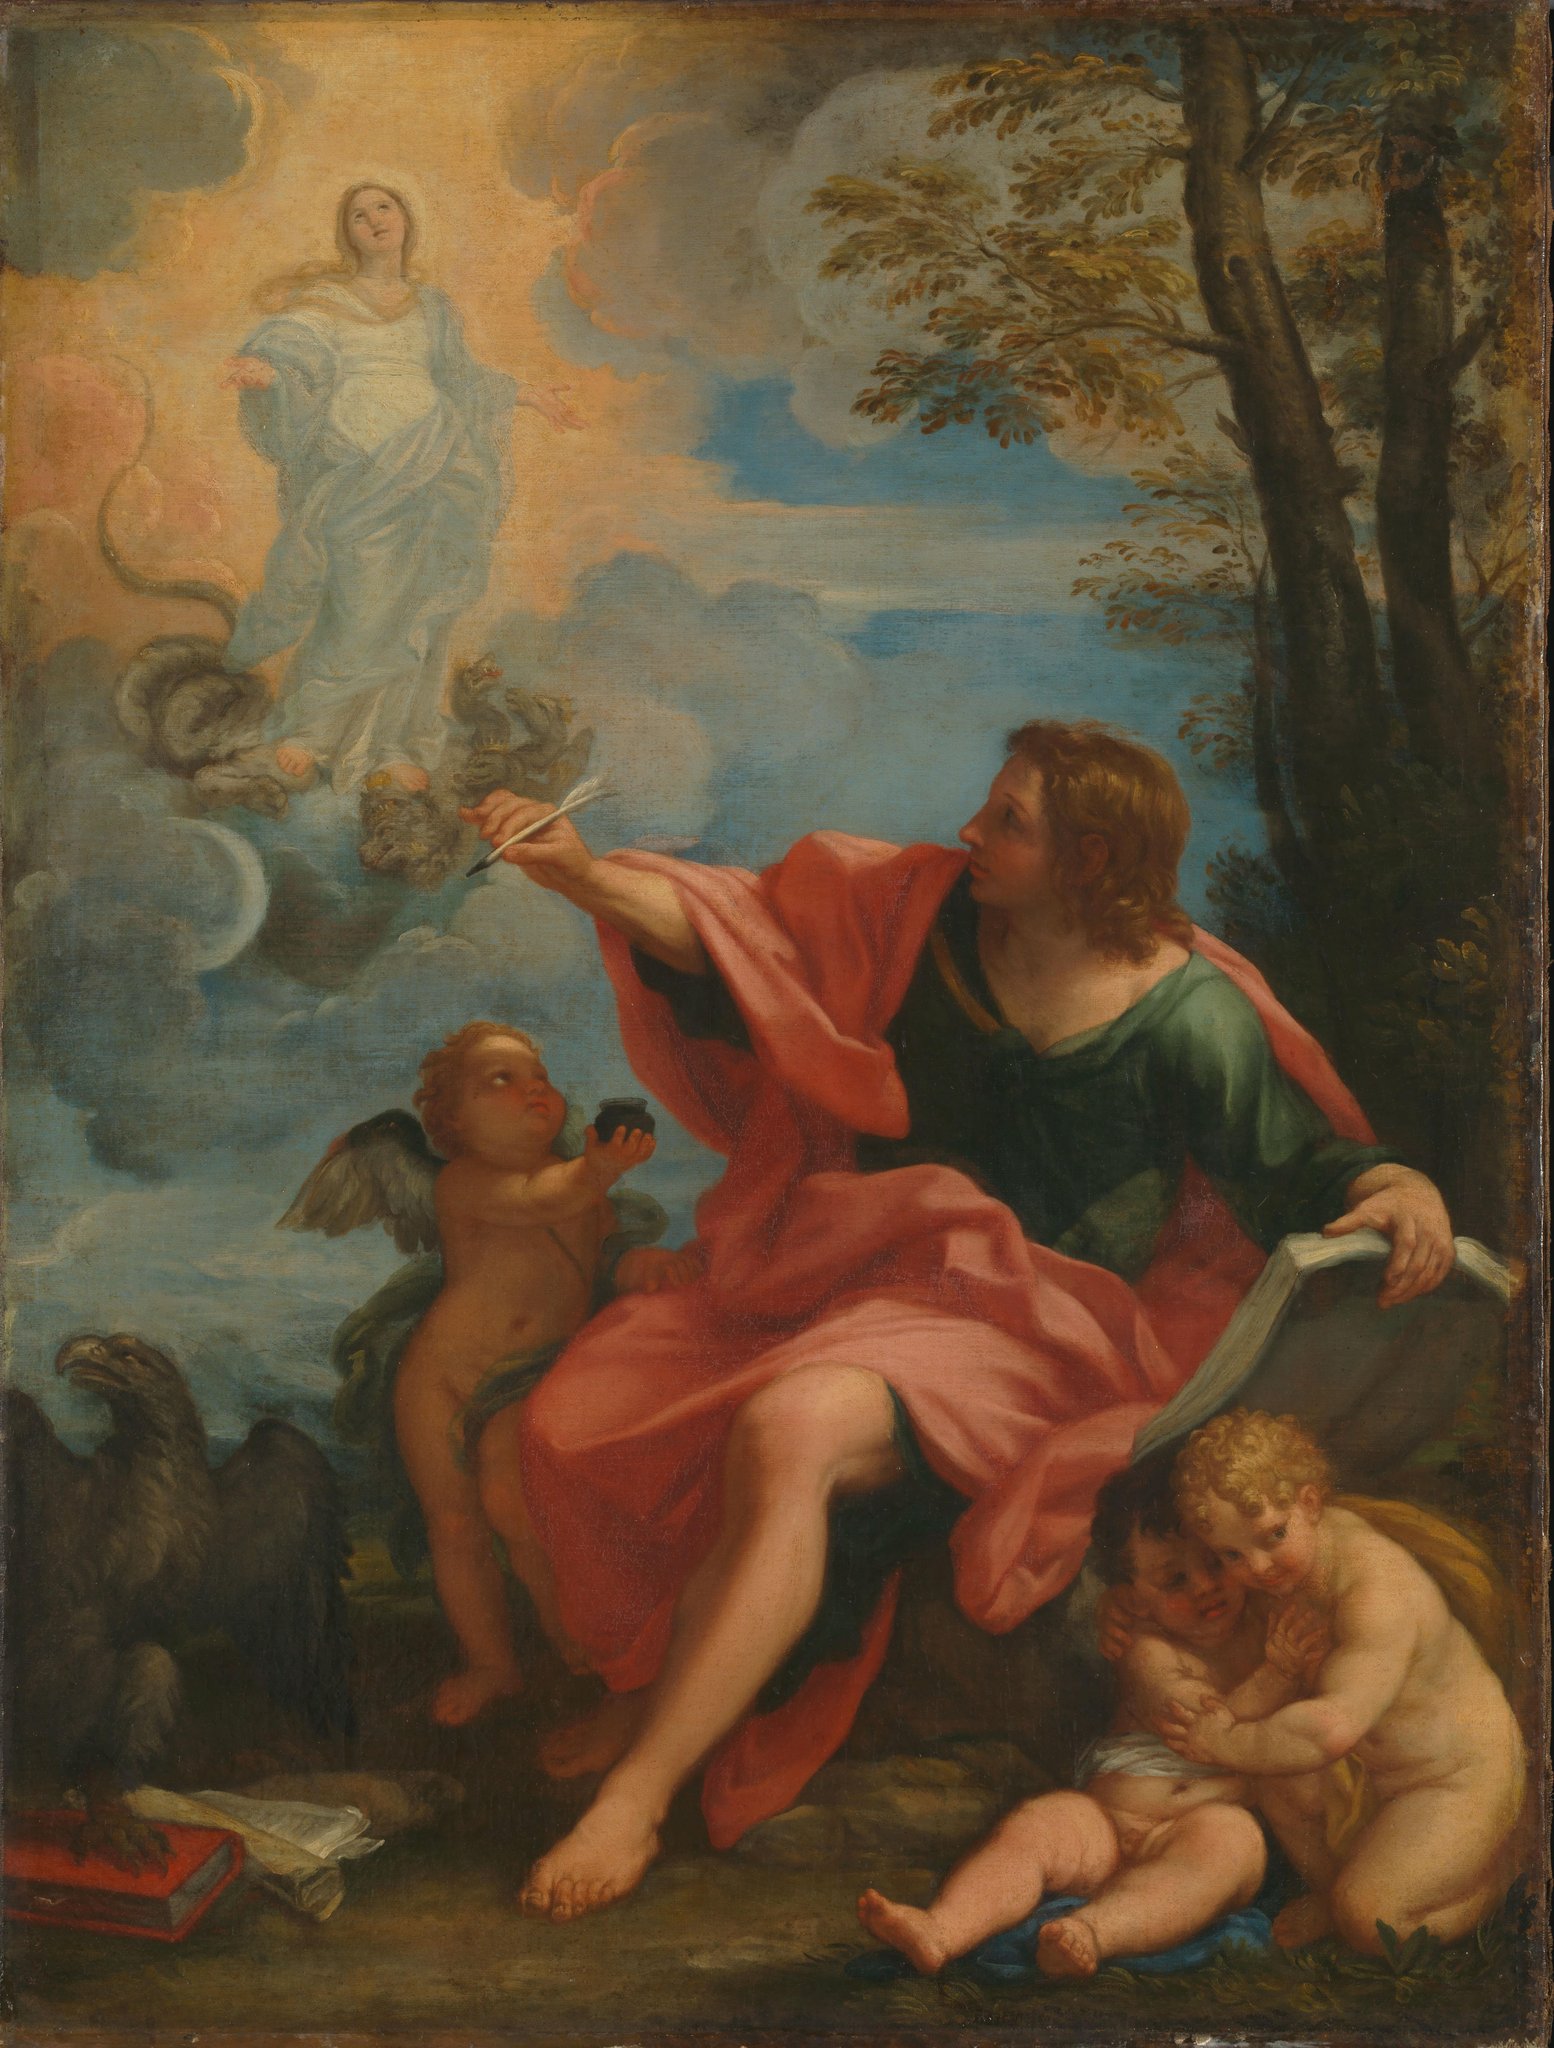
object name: painting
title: Saint John the Evangelist on Patmos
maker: carlo maratta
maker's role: draughtsman, painter, print maker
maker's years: 1625-1713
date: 1680-1720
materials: canvas, oil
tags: john (writing) on the island of patmos, possibly the eagle beside him, the pregnant woman and the dragon ~ revelation of john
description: De evangelist Johannes schrijvend op het eiland Patmos. In de hemel verschijnt een vrouw staande op de maan en een zevenkoppige draak. Johannes heeft een pen in de rechterhand, een opengeslagen boek in de linkerhand. Een engeltje houdt een inktpot omhoog. Rechts op de voorgrond twee putti die elkaar omhelzen. Links een adelaar op een boek.